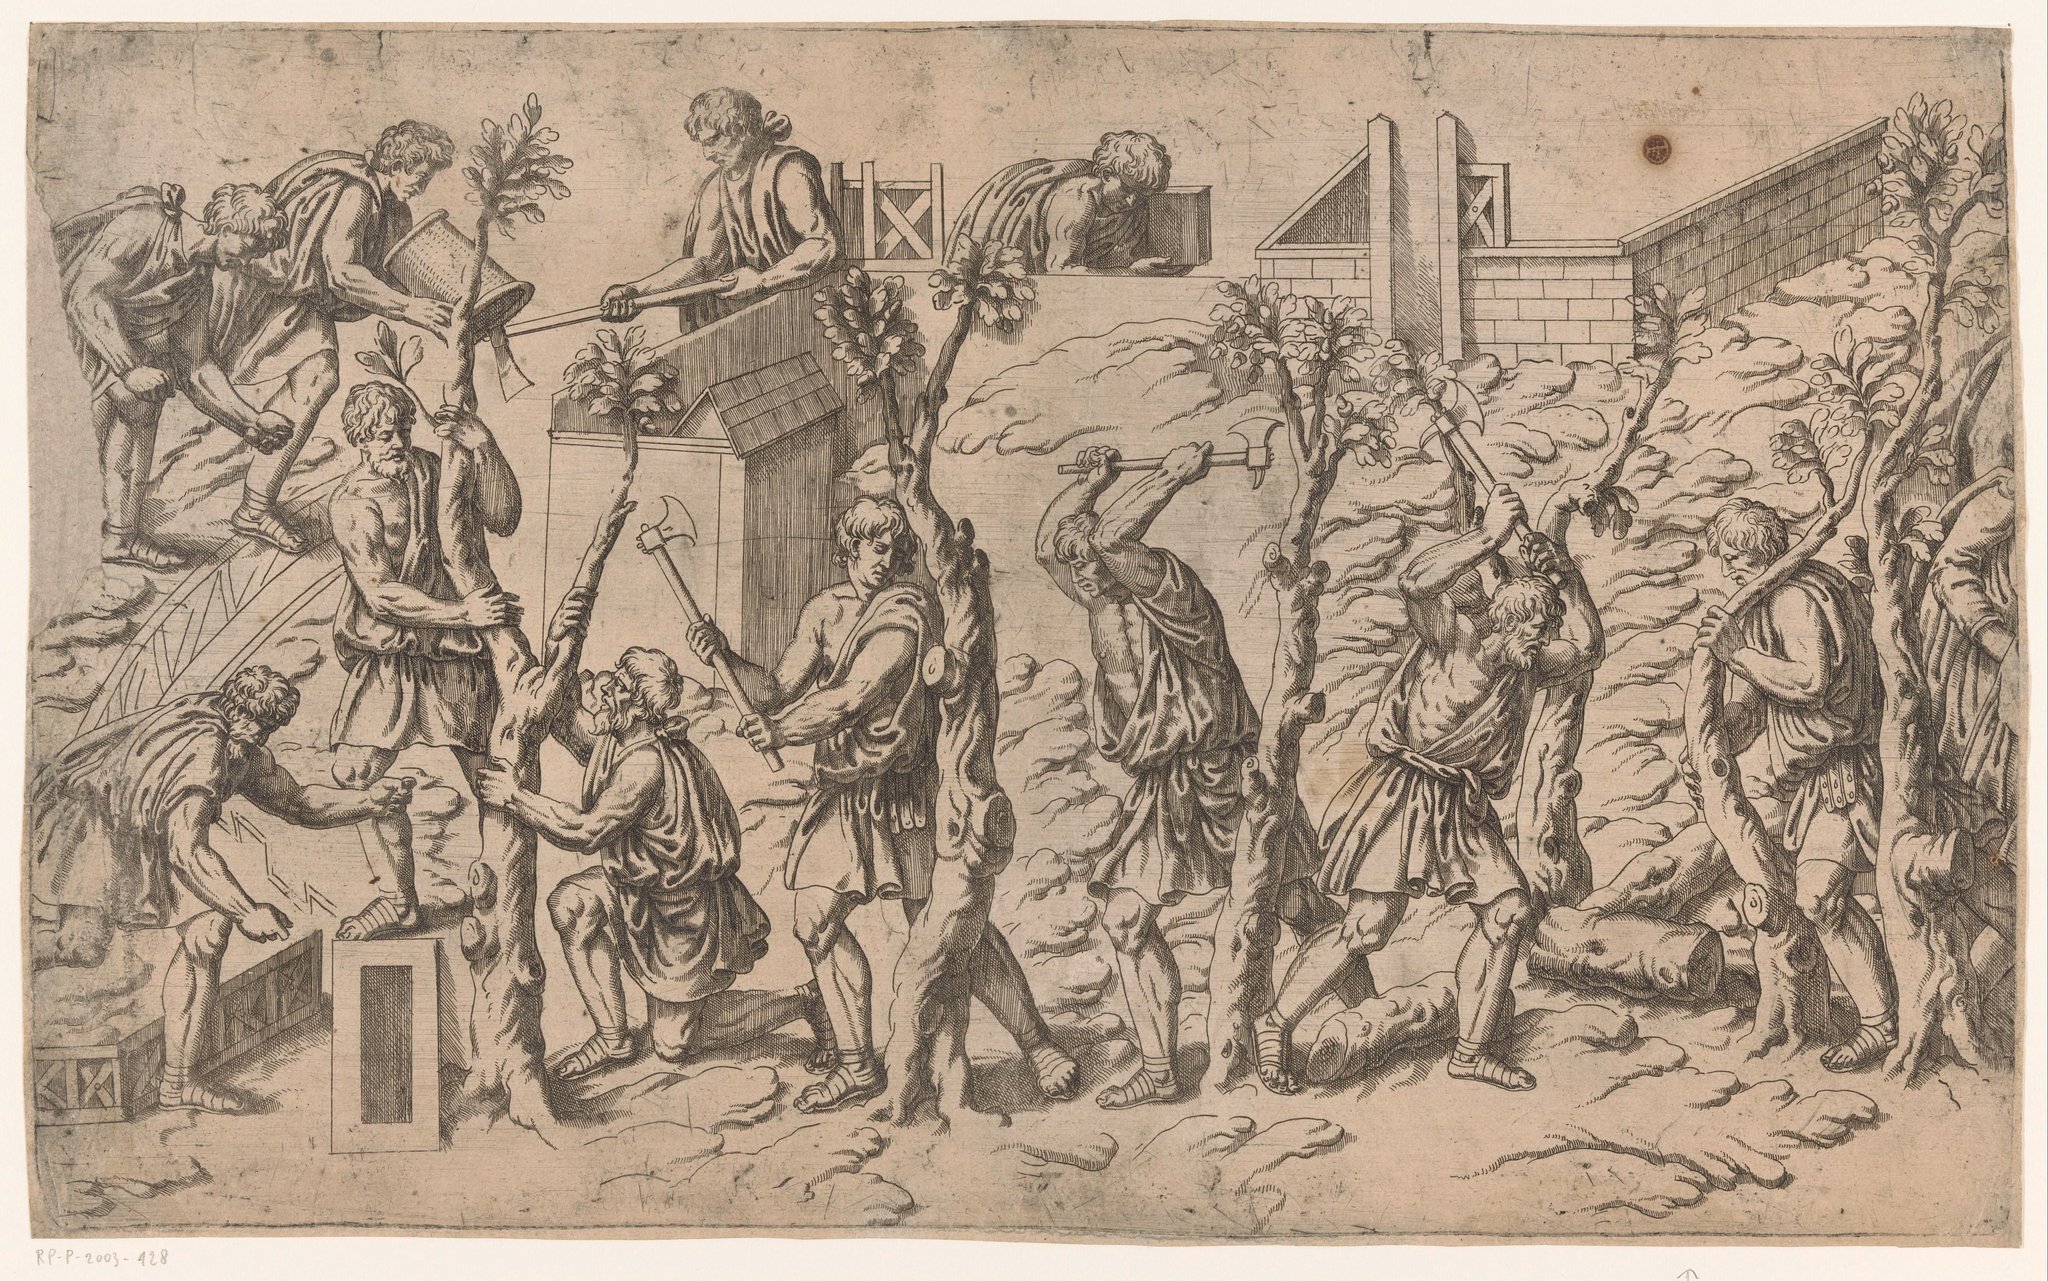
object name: print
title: Scène uit de Dacische Oorlogen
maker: antonio fantuzzi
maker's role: painter, print maker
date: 1537-1550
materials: paper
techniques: etching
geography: fontainebleau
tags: (story of) the emperor trajan, triumphal column with helical friezes, piece of sculpture, reproduction of a piece of sculpture, war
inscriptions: collector's mark, collector's mark: Lugt 2228, inscription: ‘colonna traja [...]’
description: Deze prent maakt deel uit van een fries bestaande uit een onbekend aantal prenten met voorstellingen naar het bas-reliëf op de Zuil van Trajanus te Rome. De voorstellingen op de prenten in de collectie Rijksmuseum sluiten niet op elkaar aan.